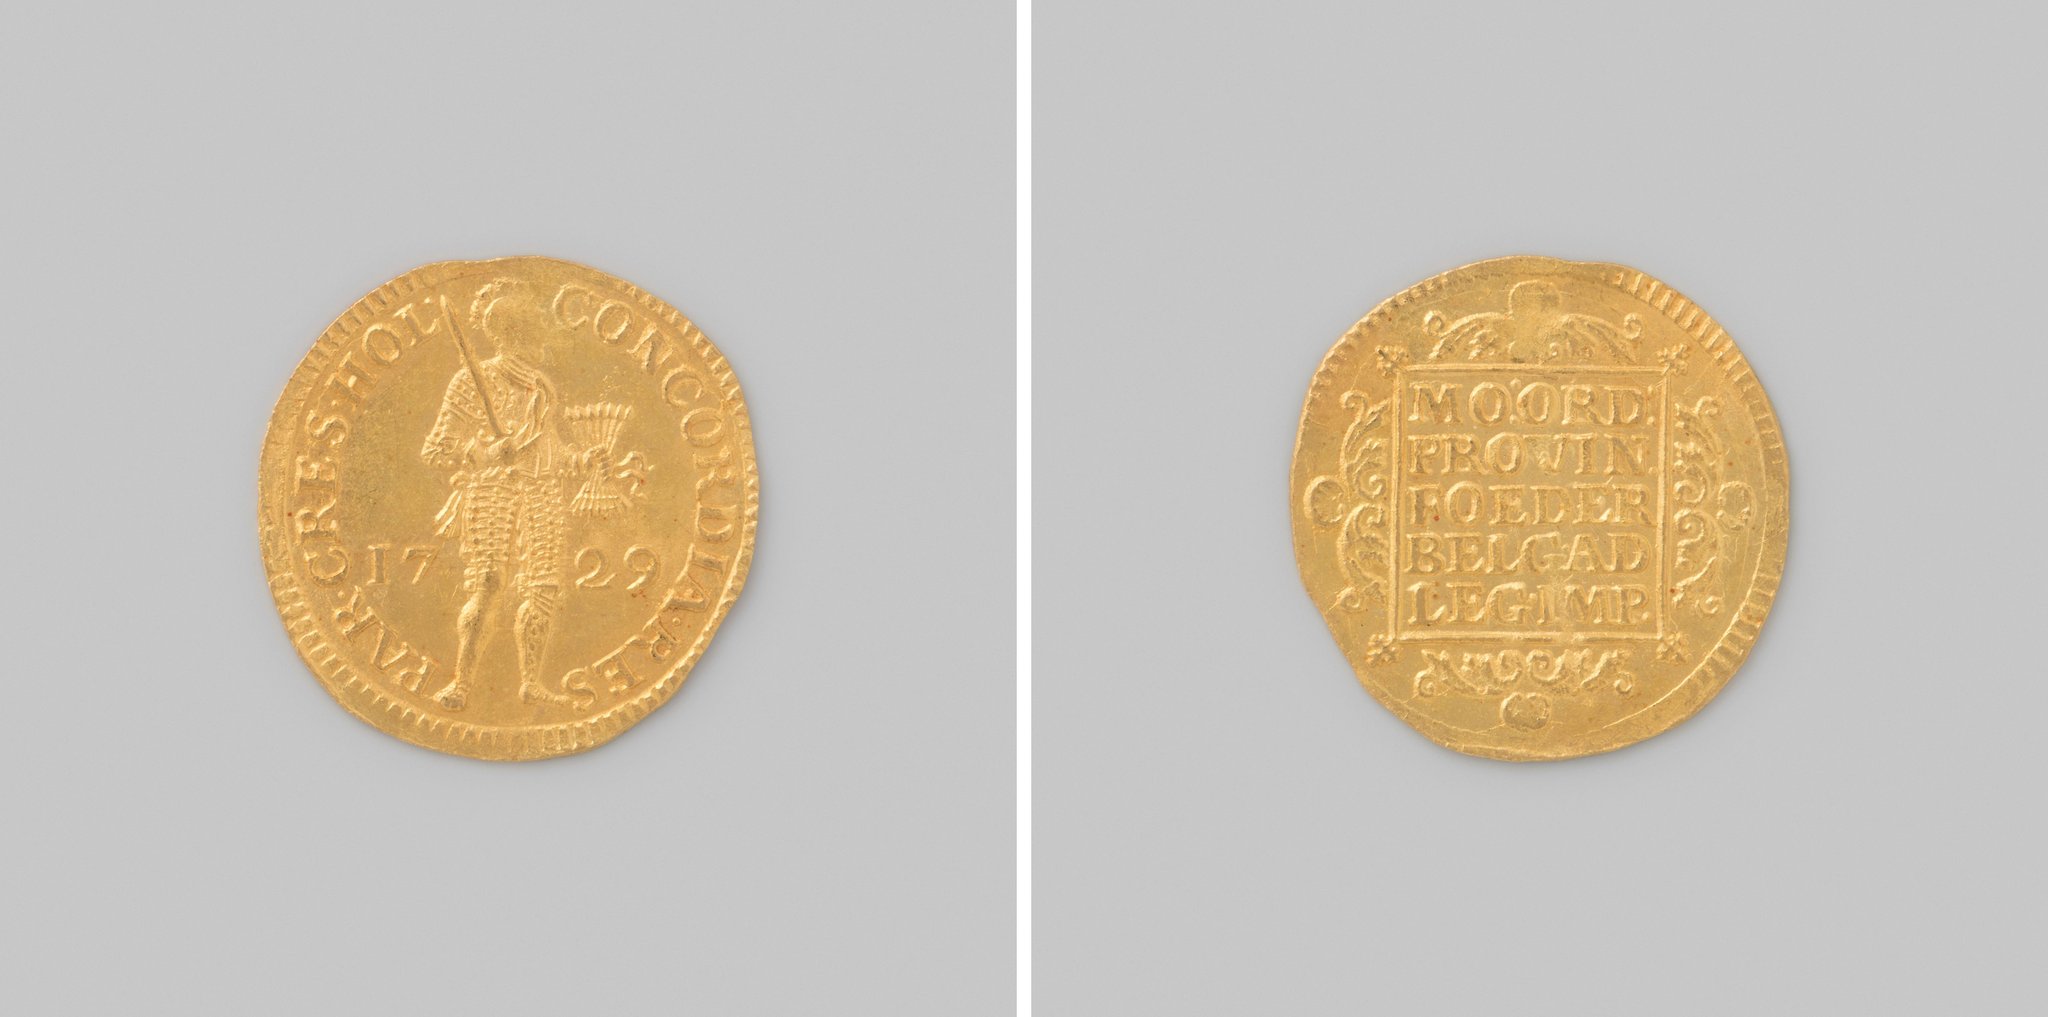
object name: ducat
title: Dukaat van goud afkomstig van het wrak van de Oost-Indiëvaarder 't Vliegend Hart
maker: Anonymous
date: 1729-1734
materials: gold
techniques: striking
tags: 't vliegend hart (schip)